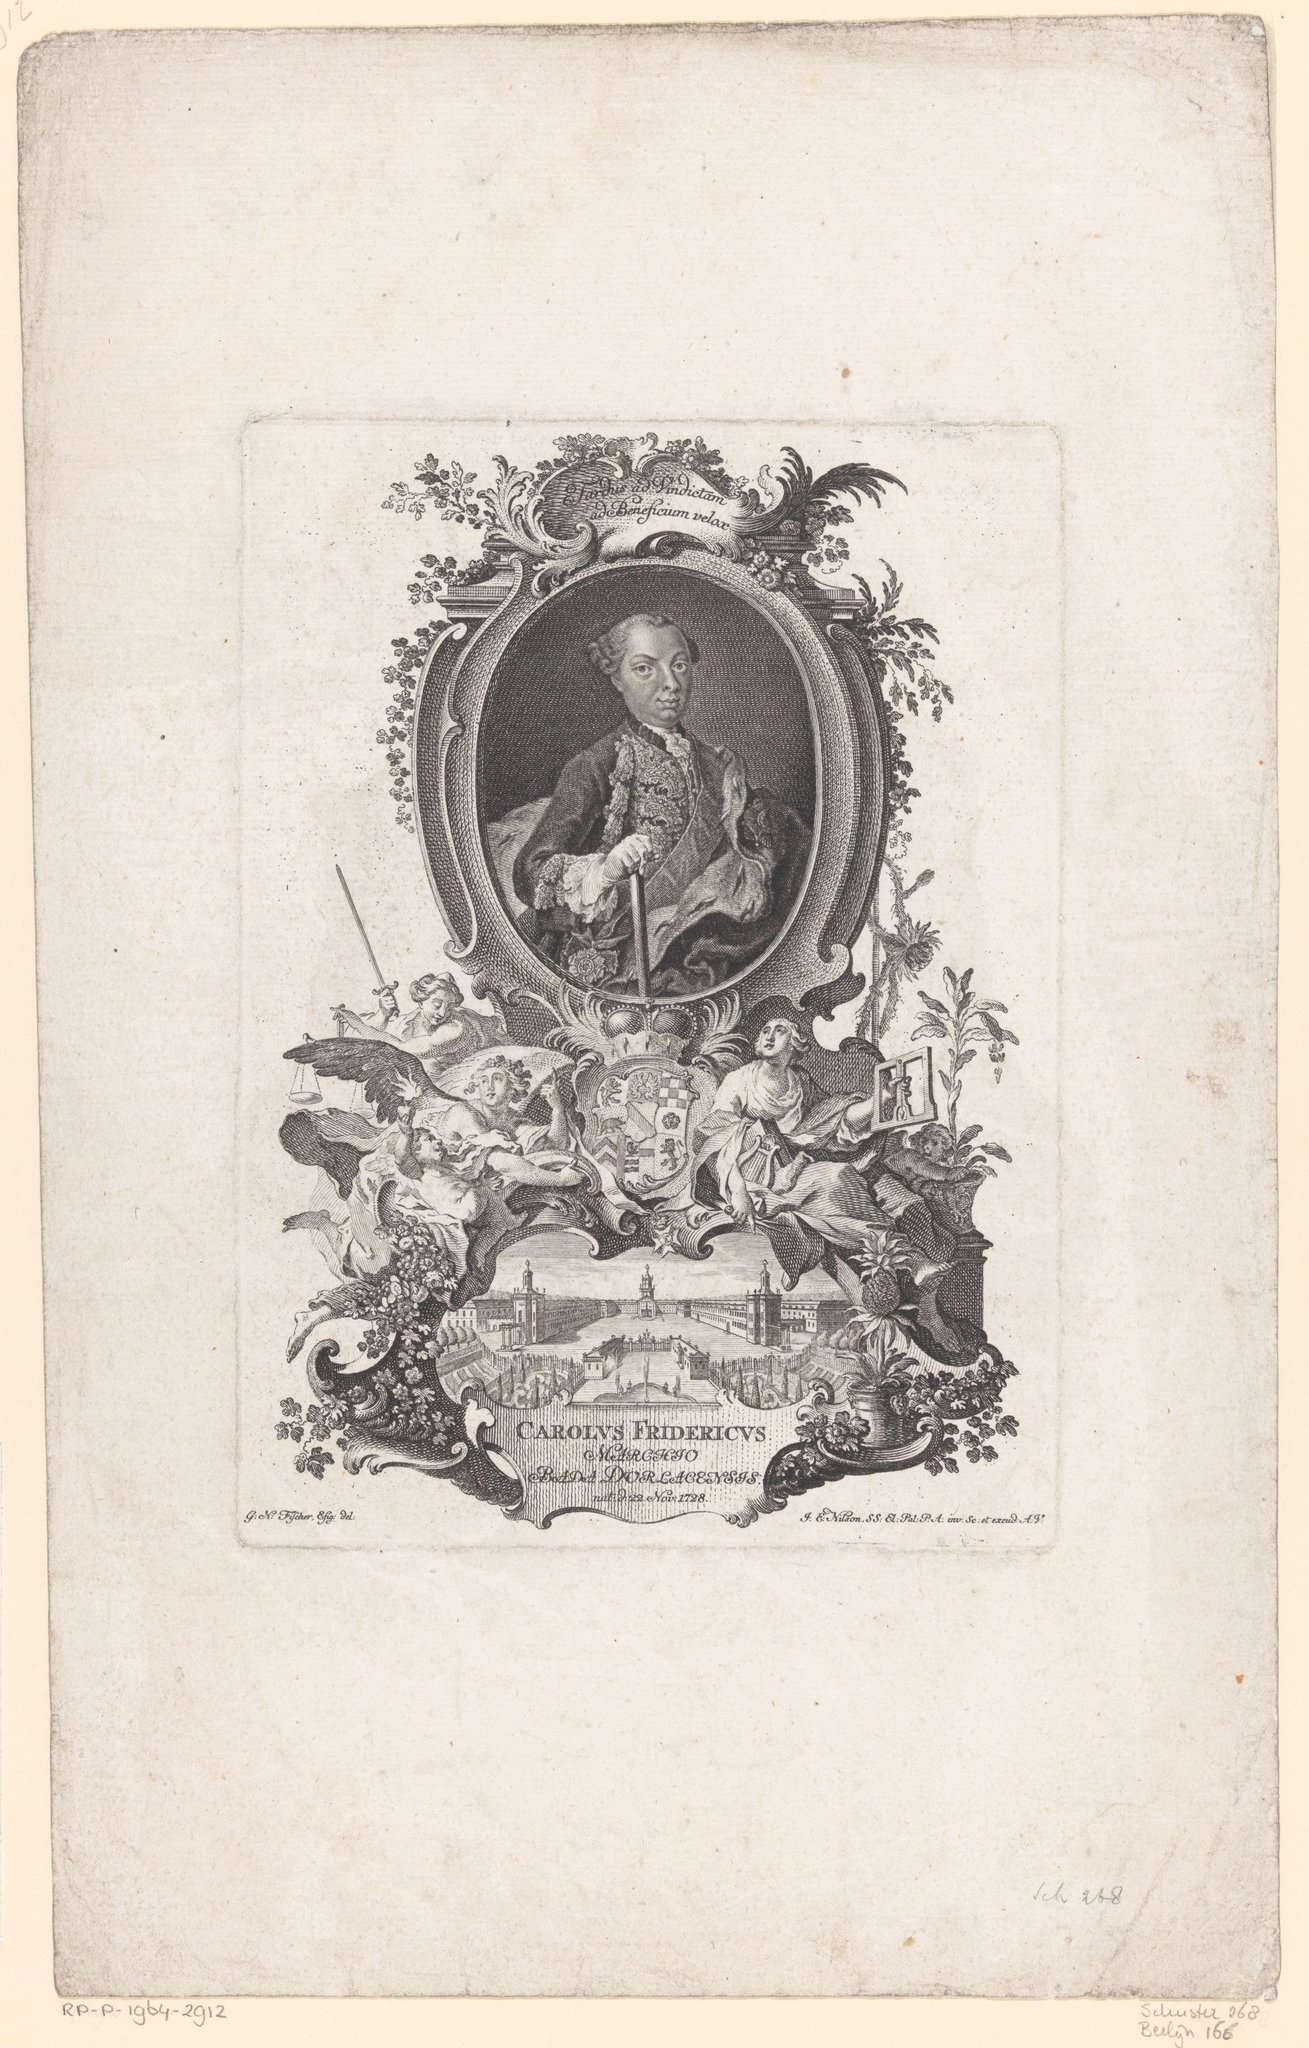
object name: ornament print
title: Portret van Karel Frederik van Baden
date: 1771-1788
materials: paper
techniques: engraving, etching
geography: augsburg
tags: historical persons, palace, ruler, sovereign, cupids: 'amores', 'amoretti', 'putti'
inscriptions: collector's mark: Lugt 2228, collector's mark: Lugt 2760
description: Portret van Karel Frederik van Baden in een rocaille omlijsting met een cartouche met het motto Tardus ad Vindictam ad Beneficium velox (Langzaam naar de bevrijding, snel naar de weldaad). Onder de omlijsting engelen en putti rondom een gekroond wapenschild en een blik op het paleis te Karlsruhe.